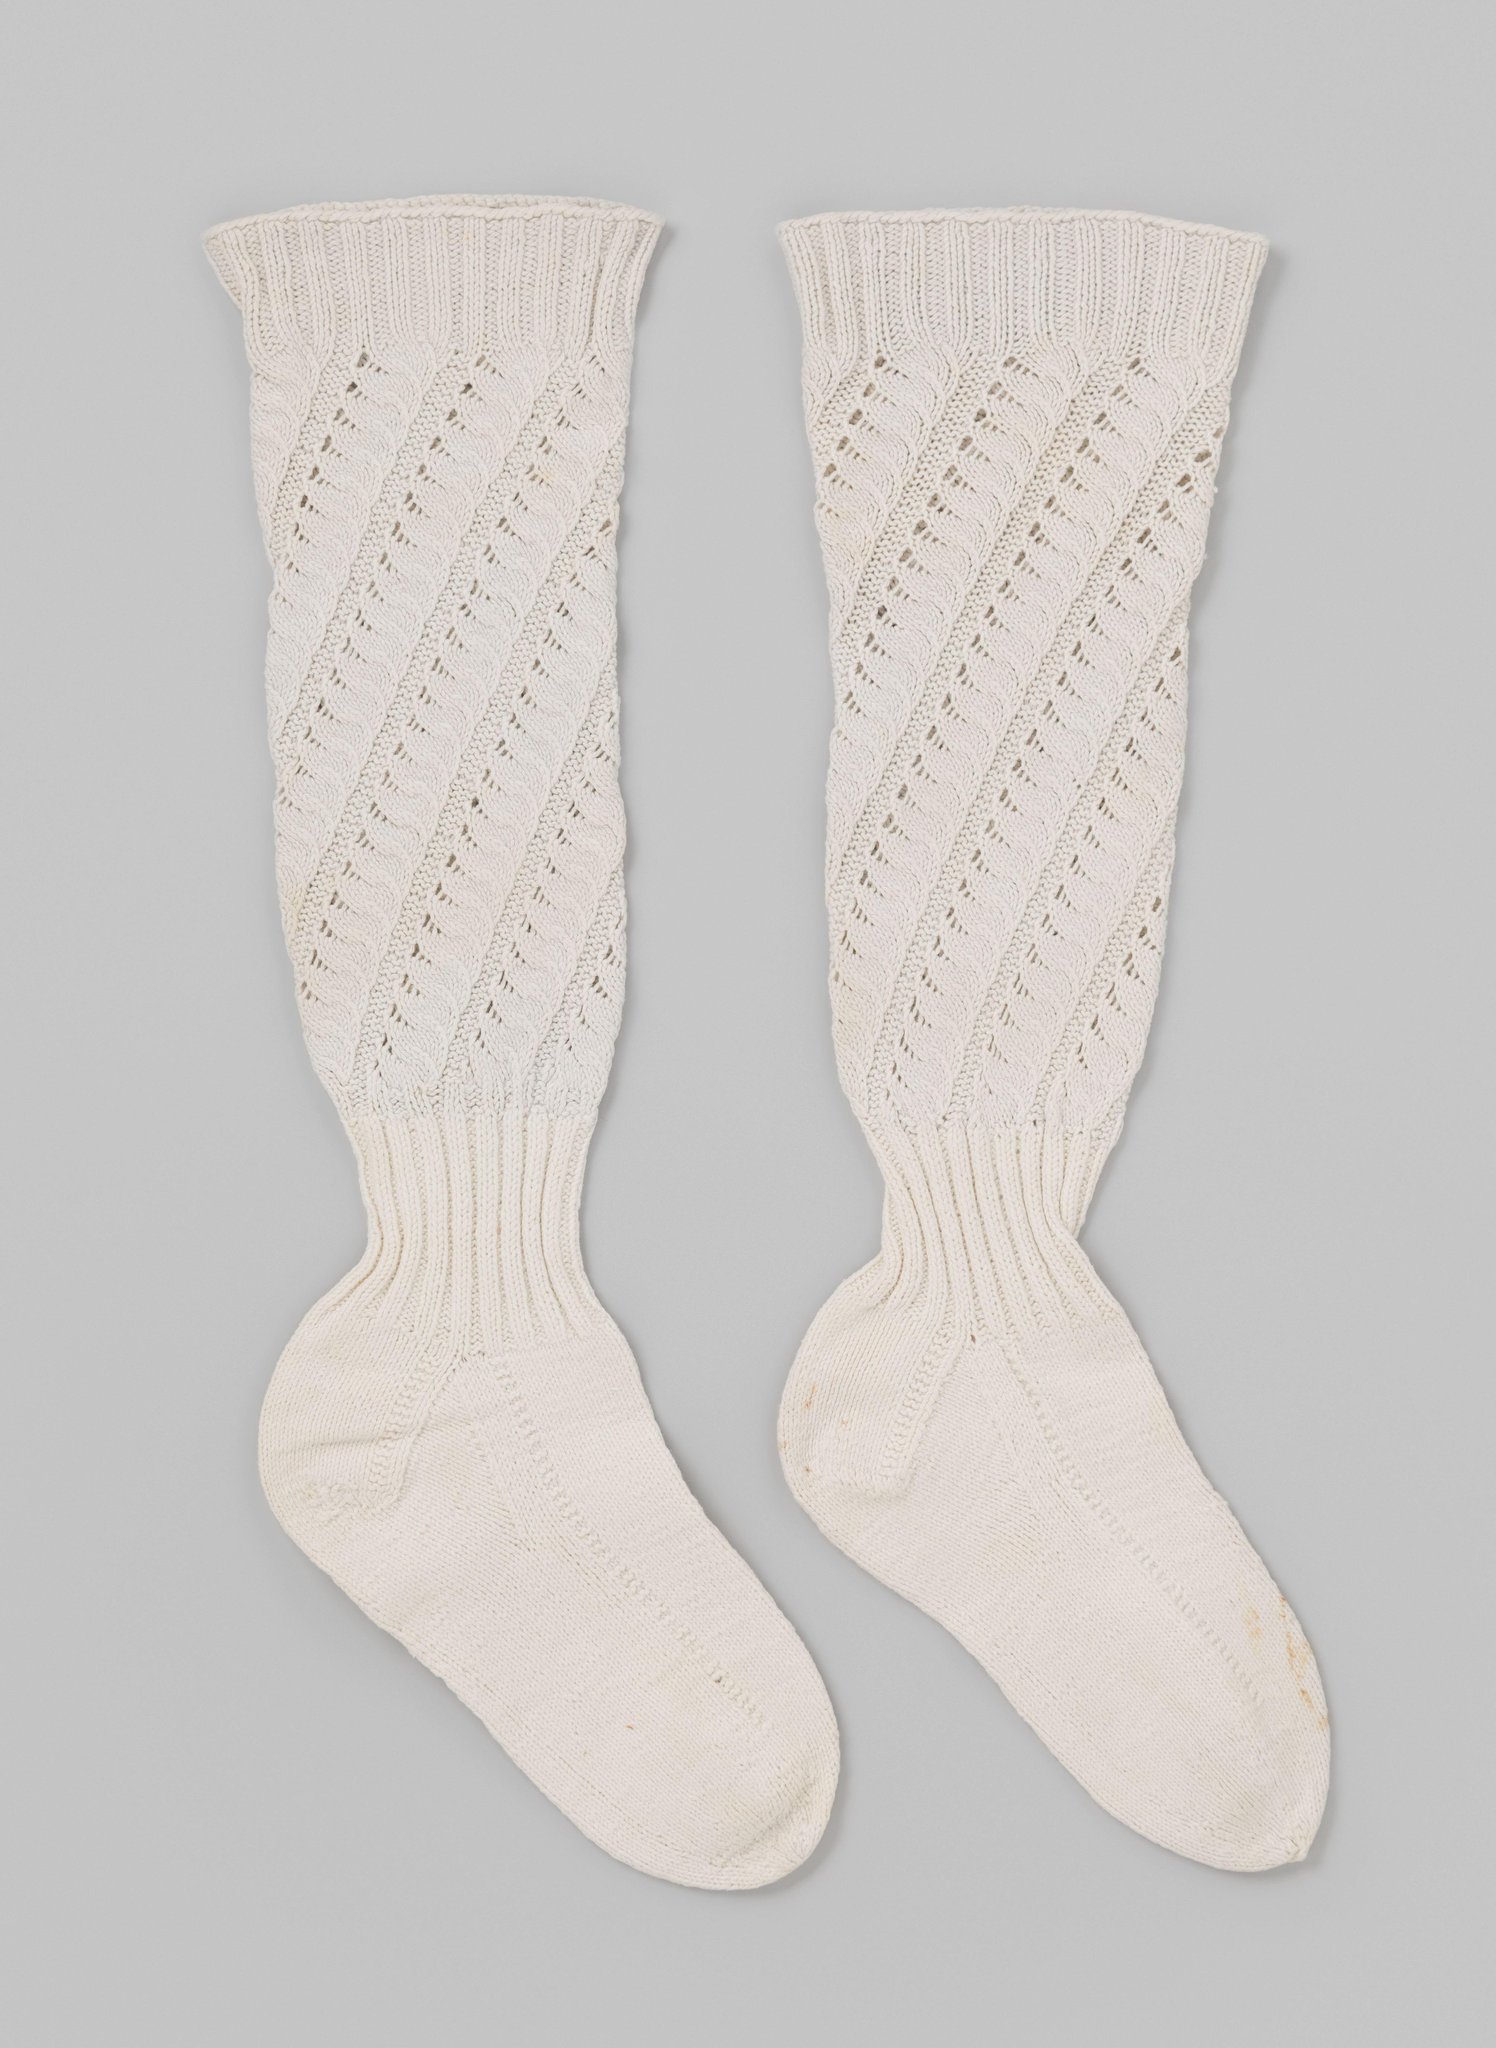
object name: stocking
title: Kous van witte katoenen tricot, met diagonaal patroon van slingerende banen, smalle boord en versmalling rond de enkel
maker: Anonymous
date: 1830-1840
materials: cotton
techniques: knitting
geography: netherlands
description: Kous van dikke witte katoenen tricot, met diagonaal patroon van slingerende banen, smalle boord en versmalling rond de enkel. Voet en enkel deel zijn aangebreid, te zien aan het lichte kleurverschil.